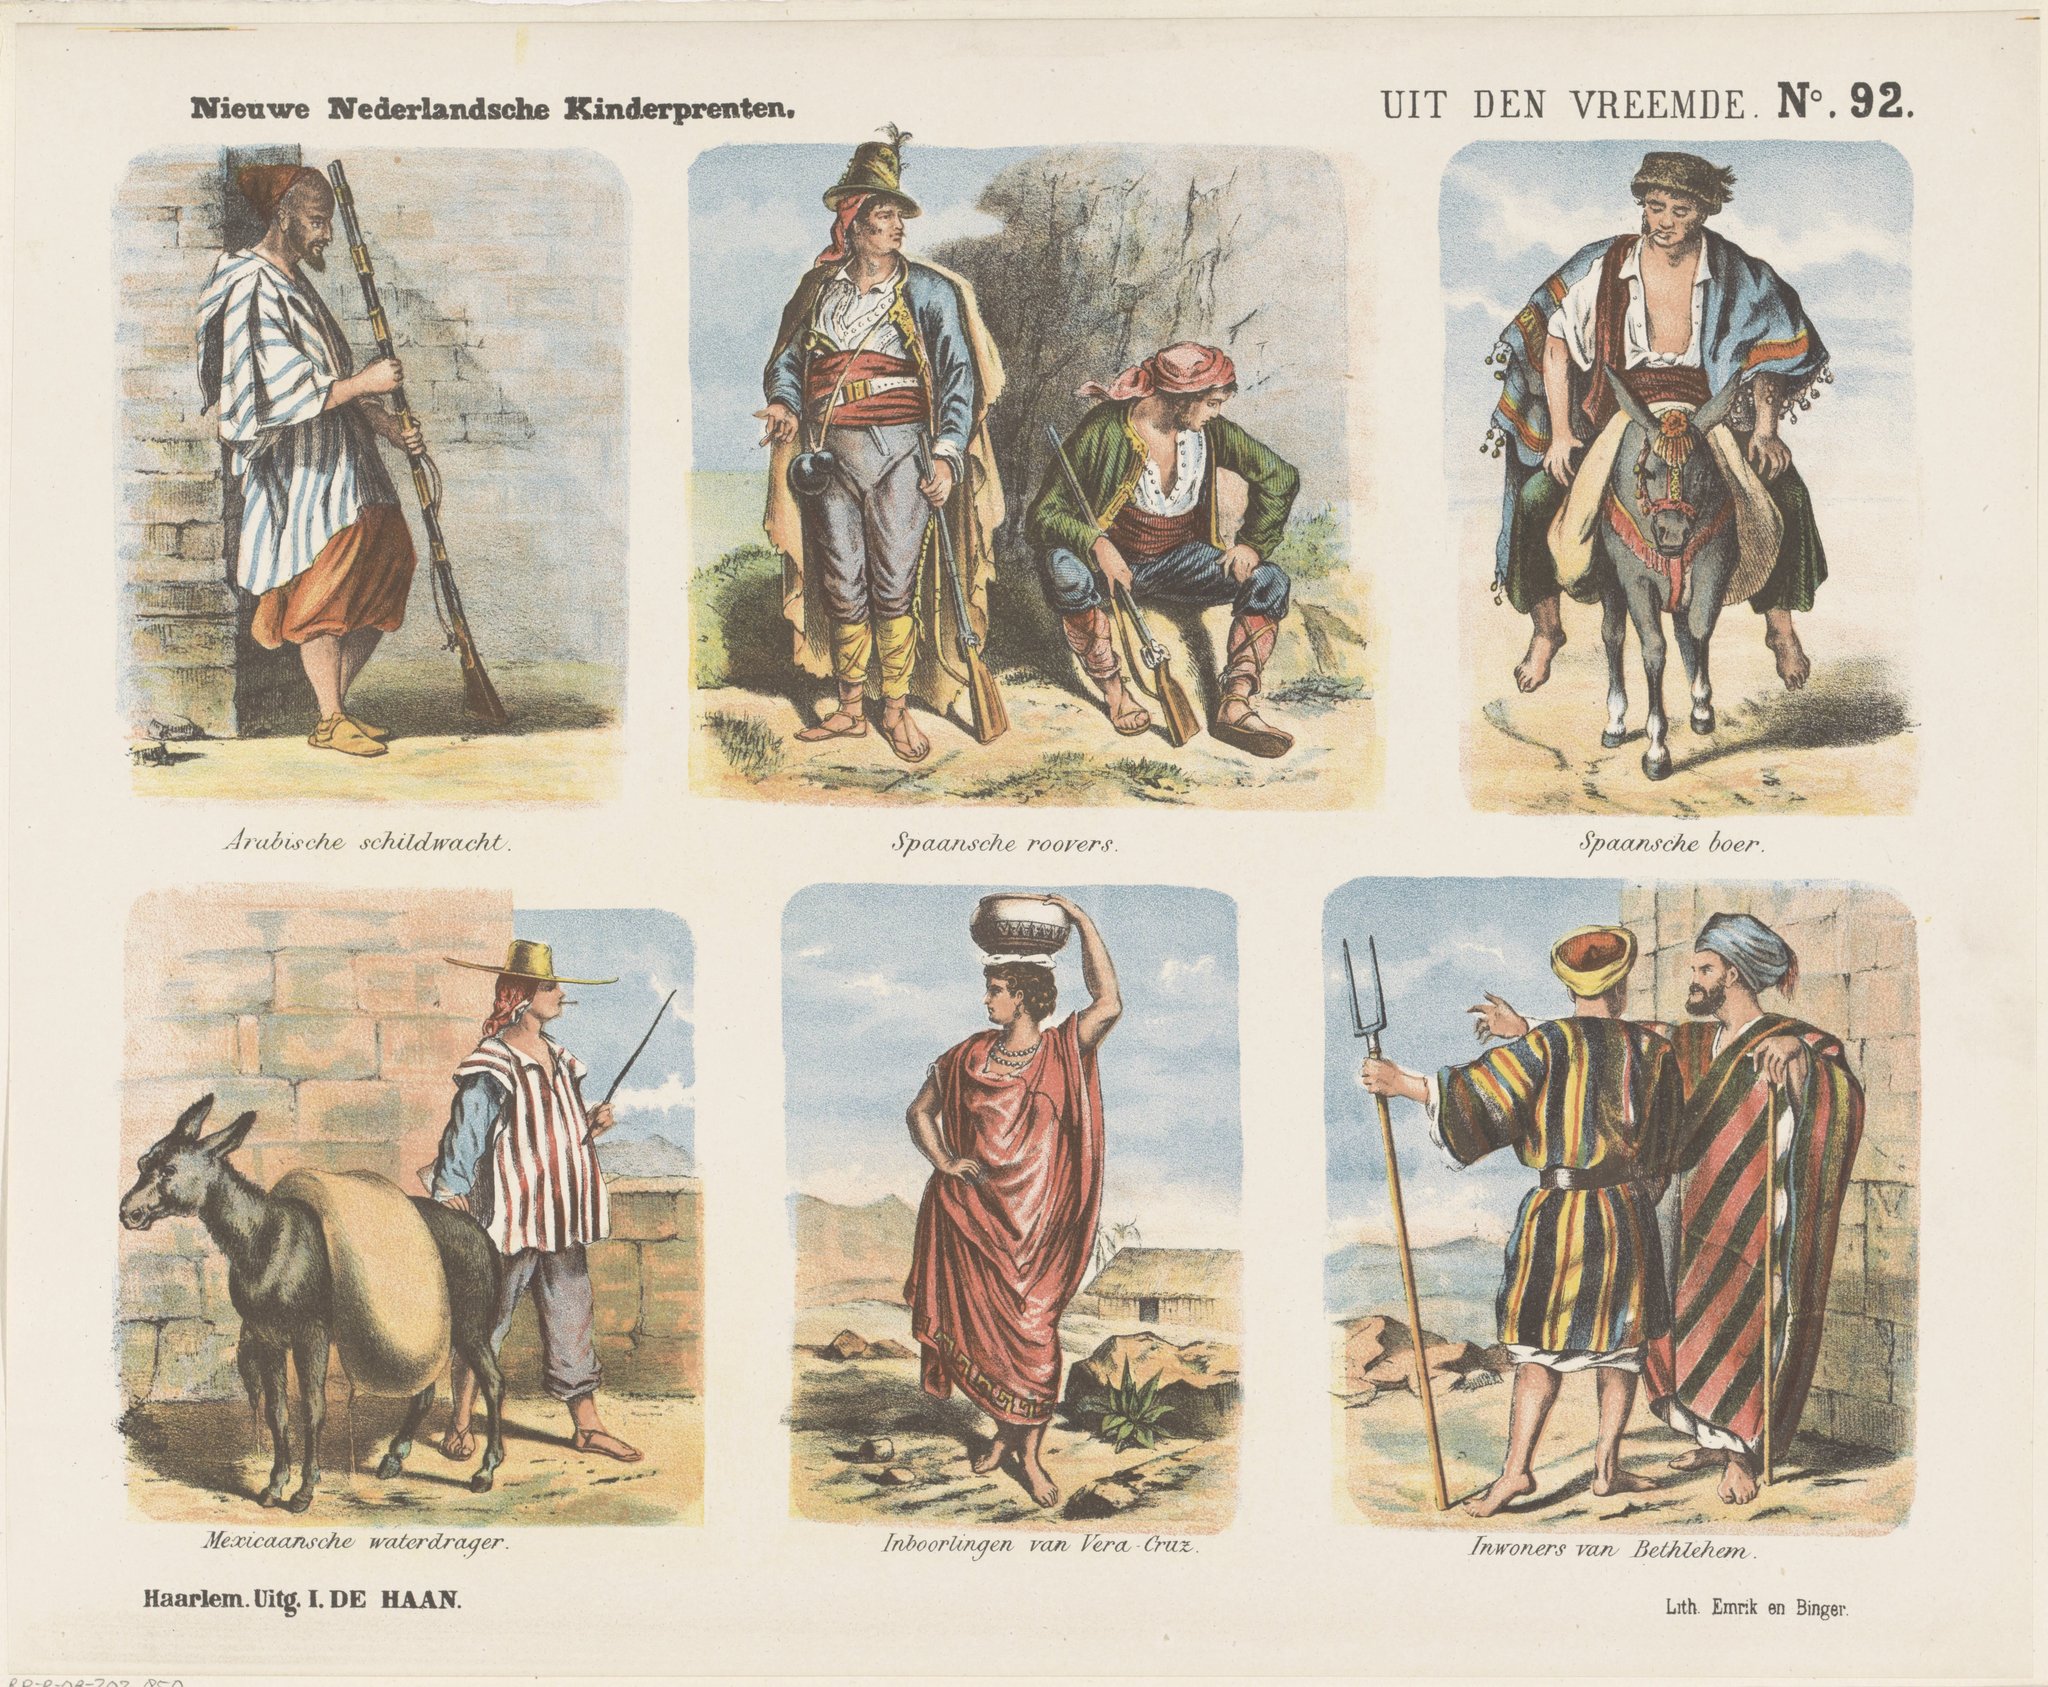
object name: popular print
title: Nieuwe Nederlandsche kinderprenten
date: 1875-1903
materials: paper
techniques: lithograph, letterpress printing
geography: haarlem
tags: robber, farmers, characters (human types)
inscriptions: collector's mark: Lugt 2760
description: Blad met 6 voorstellingen van figuren uit verschillende delen van de wereld, zoals een Arabische schildwacht, een Spaanse rover en een Mexicaanse waterdrager. Onder elke afbeelding een onderschrift. Genummerd rechtsboven: No. 92.